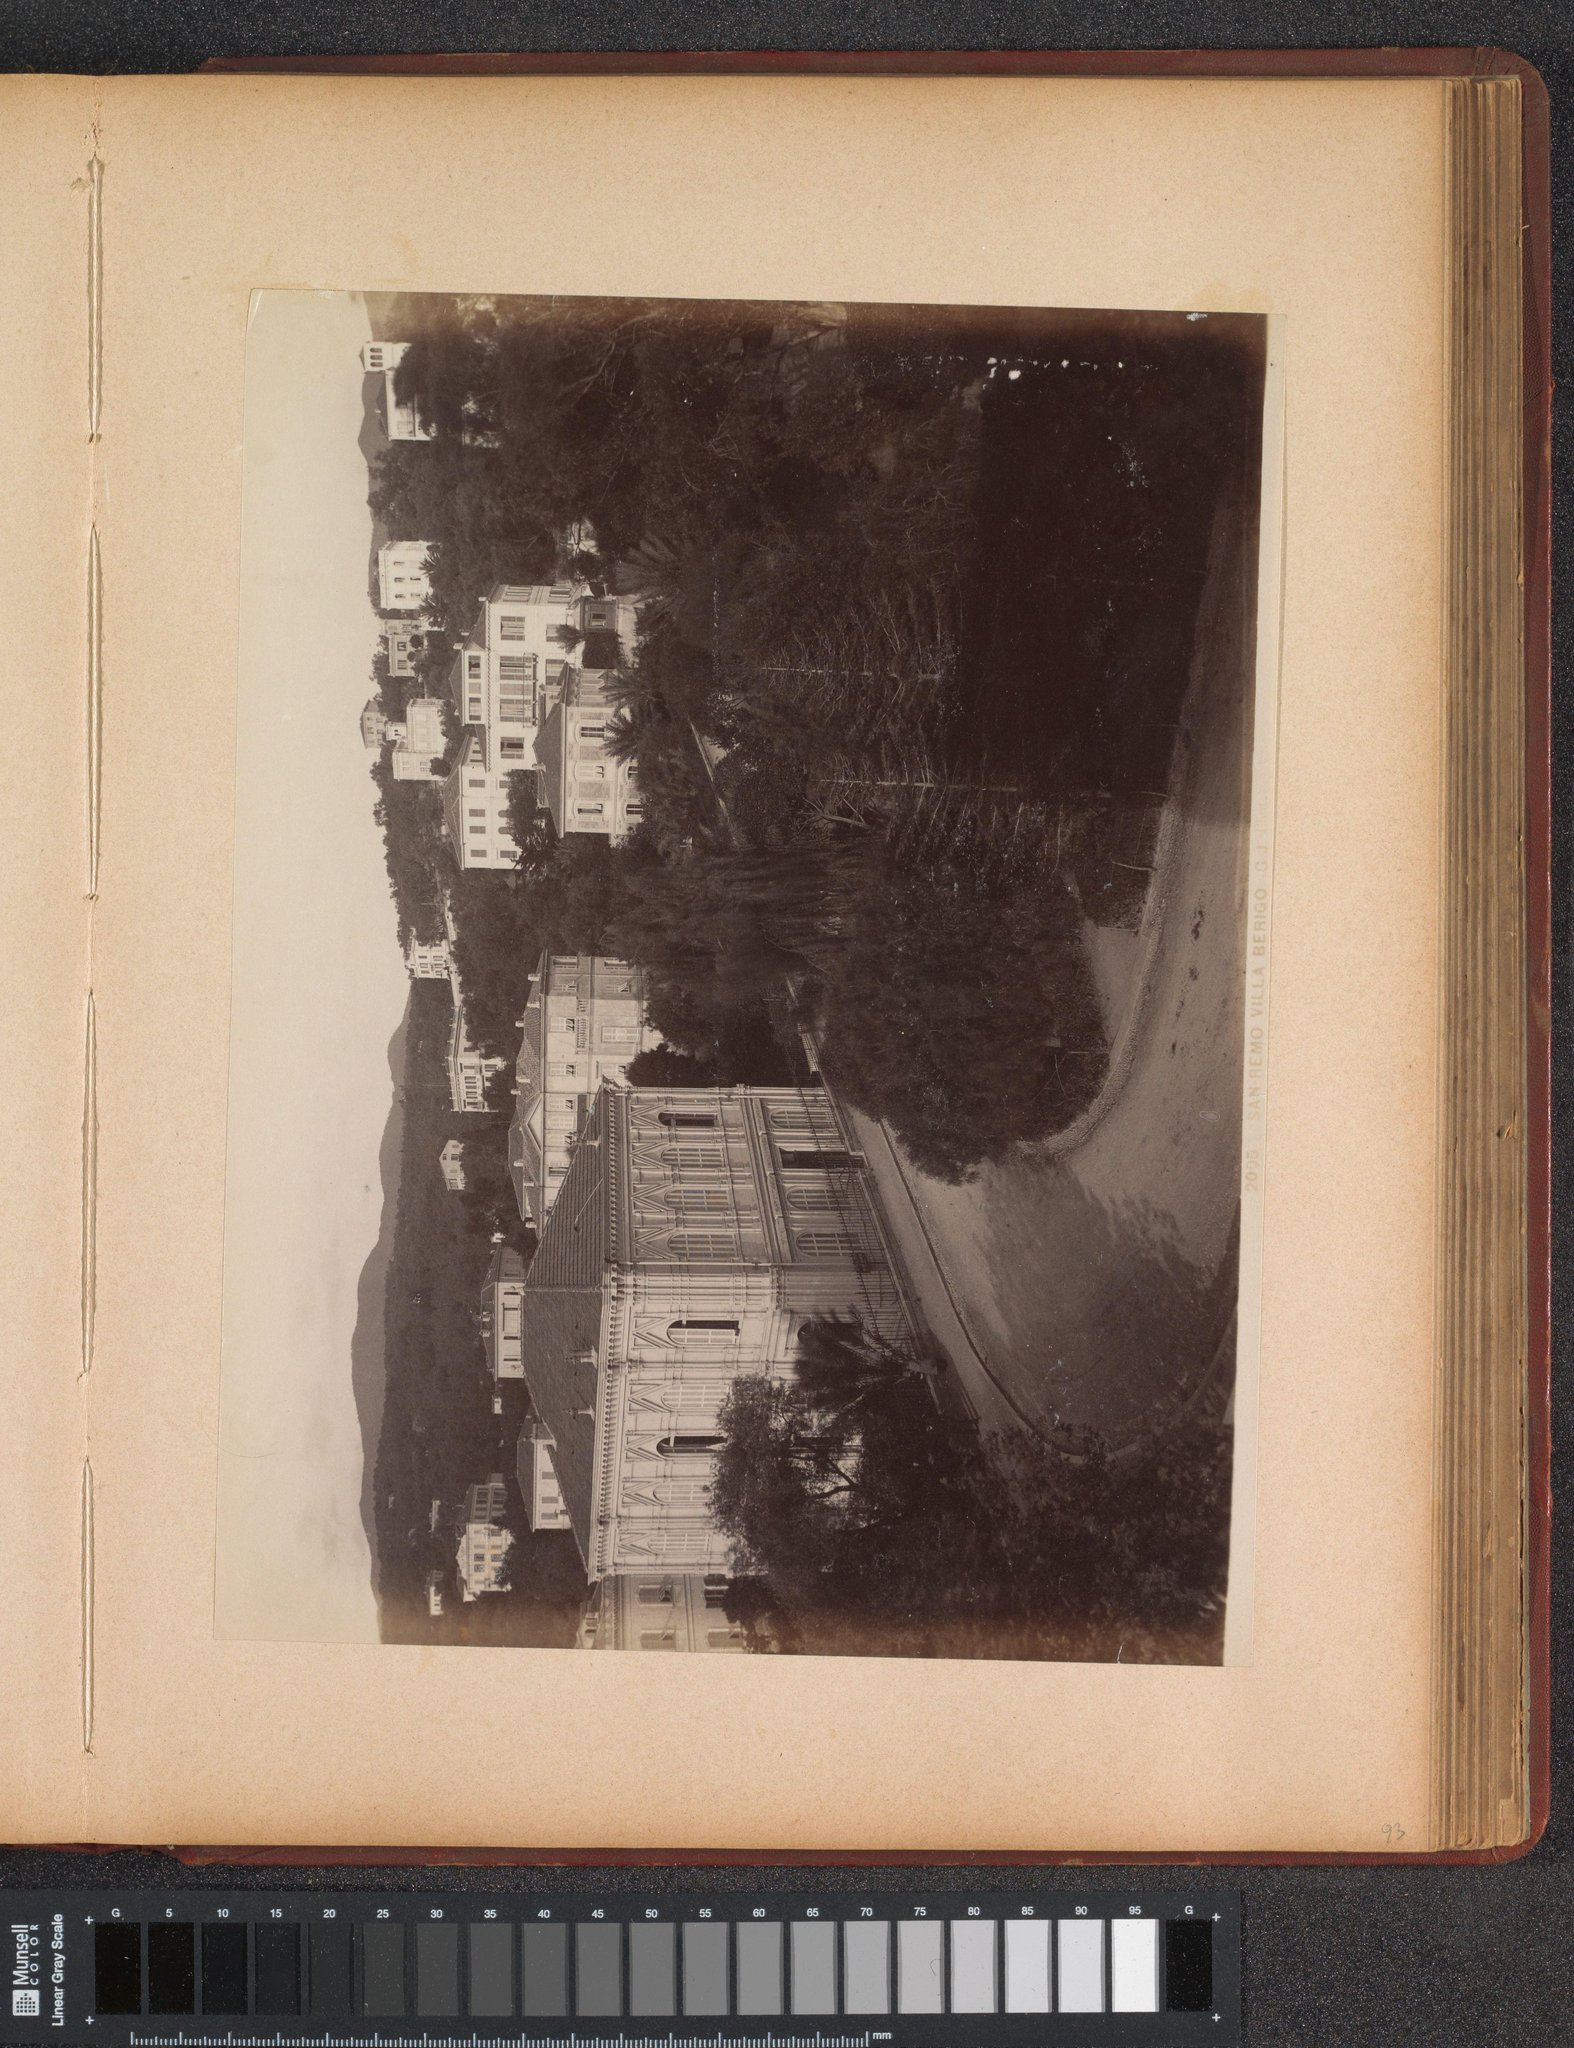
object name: photograph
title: Gezicht op Villa Berigo in San Remo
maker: jean gilletta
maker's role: fotograaf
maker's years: 1856-1933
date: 1870-1900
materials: paper, photographic support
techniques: albumen print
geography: san remo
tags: villa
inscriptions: negative number: ‘2005’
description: Onderdeel van Reisalbum met foto's van bezienswaardigheden in Italië en Zuid-Frankrijk.